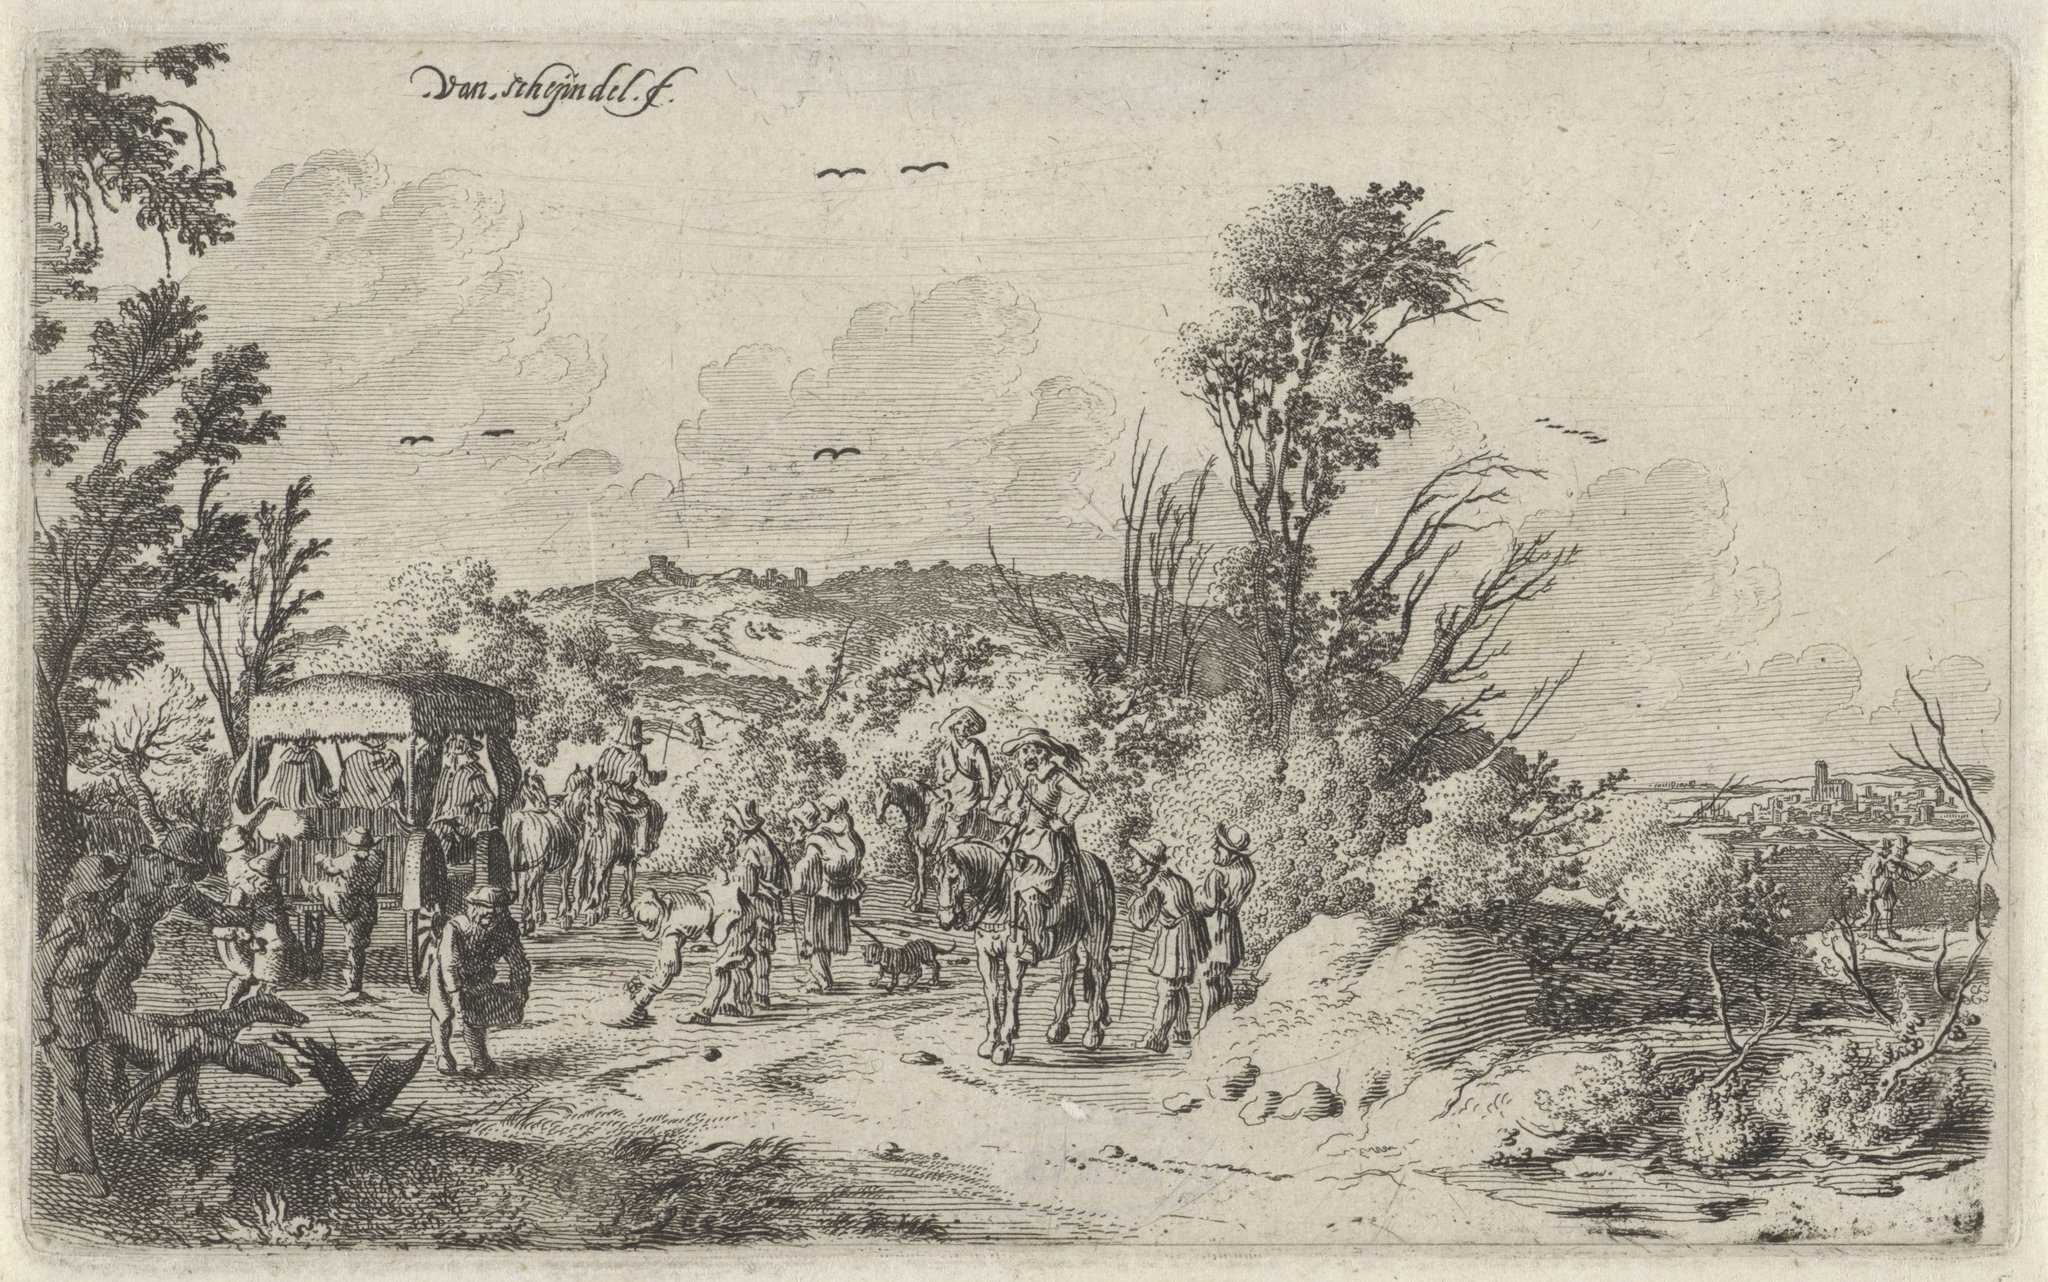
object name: print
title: Reuk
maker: gillis van scheyndel (i)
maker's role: draughtsman, print maker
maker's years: 1595-1660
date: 1605-1653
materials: paper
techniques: engraving, etching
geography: netherlands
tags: hunting dogs, hunter, smell, smelling (one of the five senses)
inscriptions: collector's mark: Lugt 2228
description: De reuk. Op een landweg in een heuvelachtig landschap bevinden zich een rijtuig, ruiters en mannen met honden. Op de voorgrond twee jagers met honden, die een spoor lijken te volgen. De prent maakt deel uit van een serie van landschappen met de vijf zintuigen.